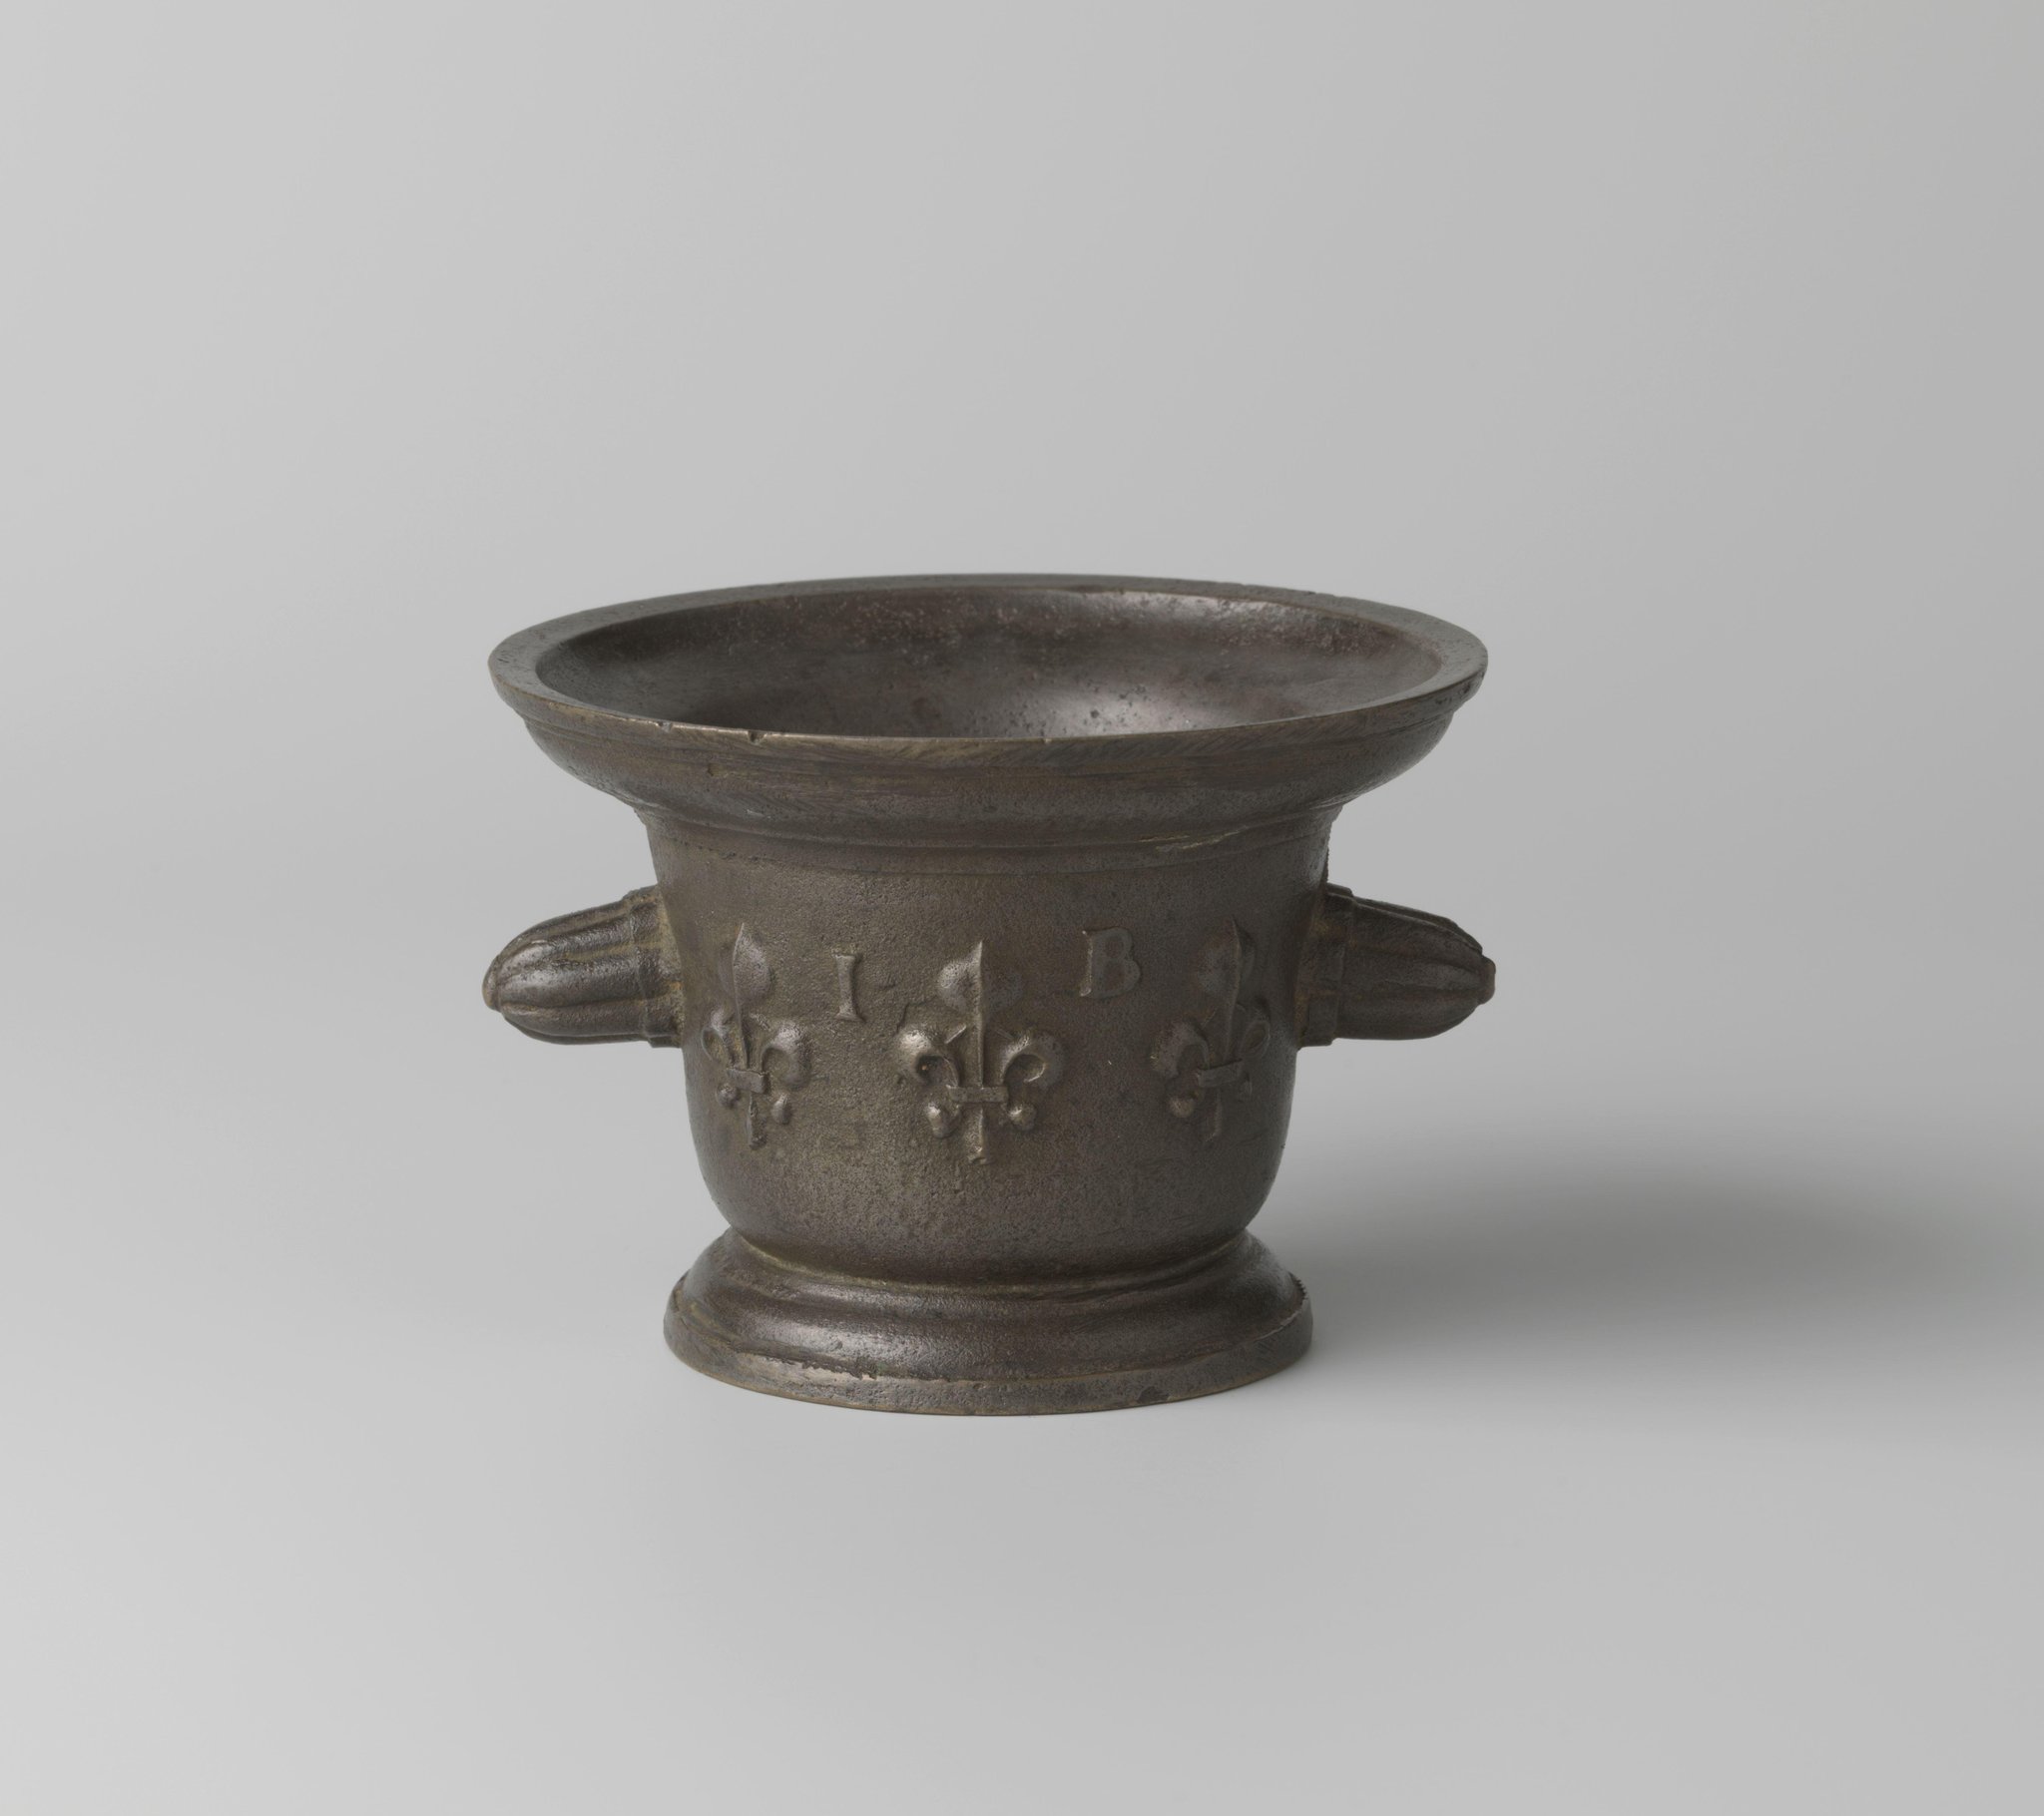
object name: mortar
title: Vijzel met Franse lelies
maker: Anonymous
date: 1600-1800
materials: bronze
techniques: casting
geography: france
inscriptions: inscription: ‘IB’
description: Mortar. Bronze. France, 17th or 18th century.